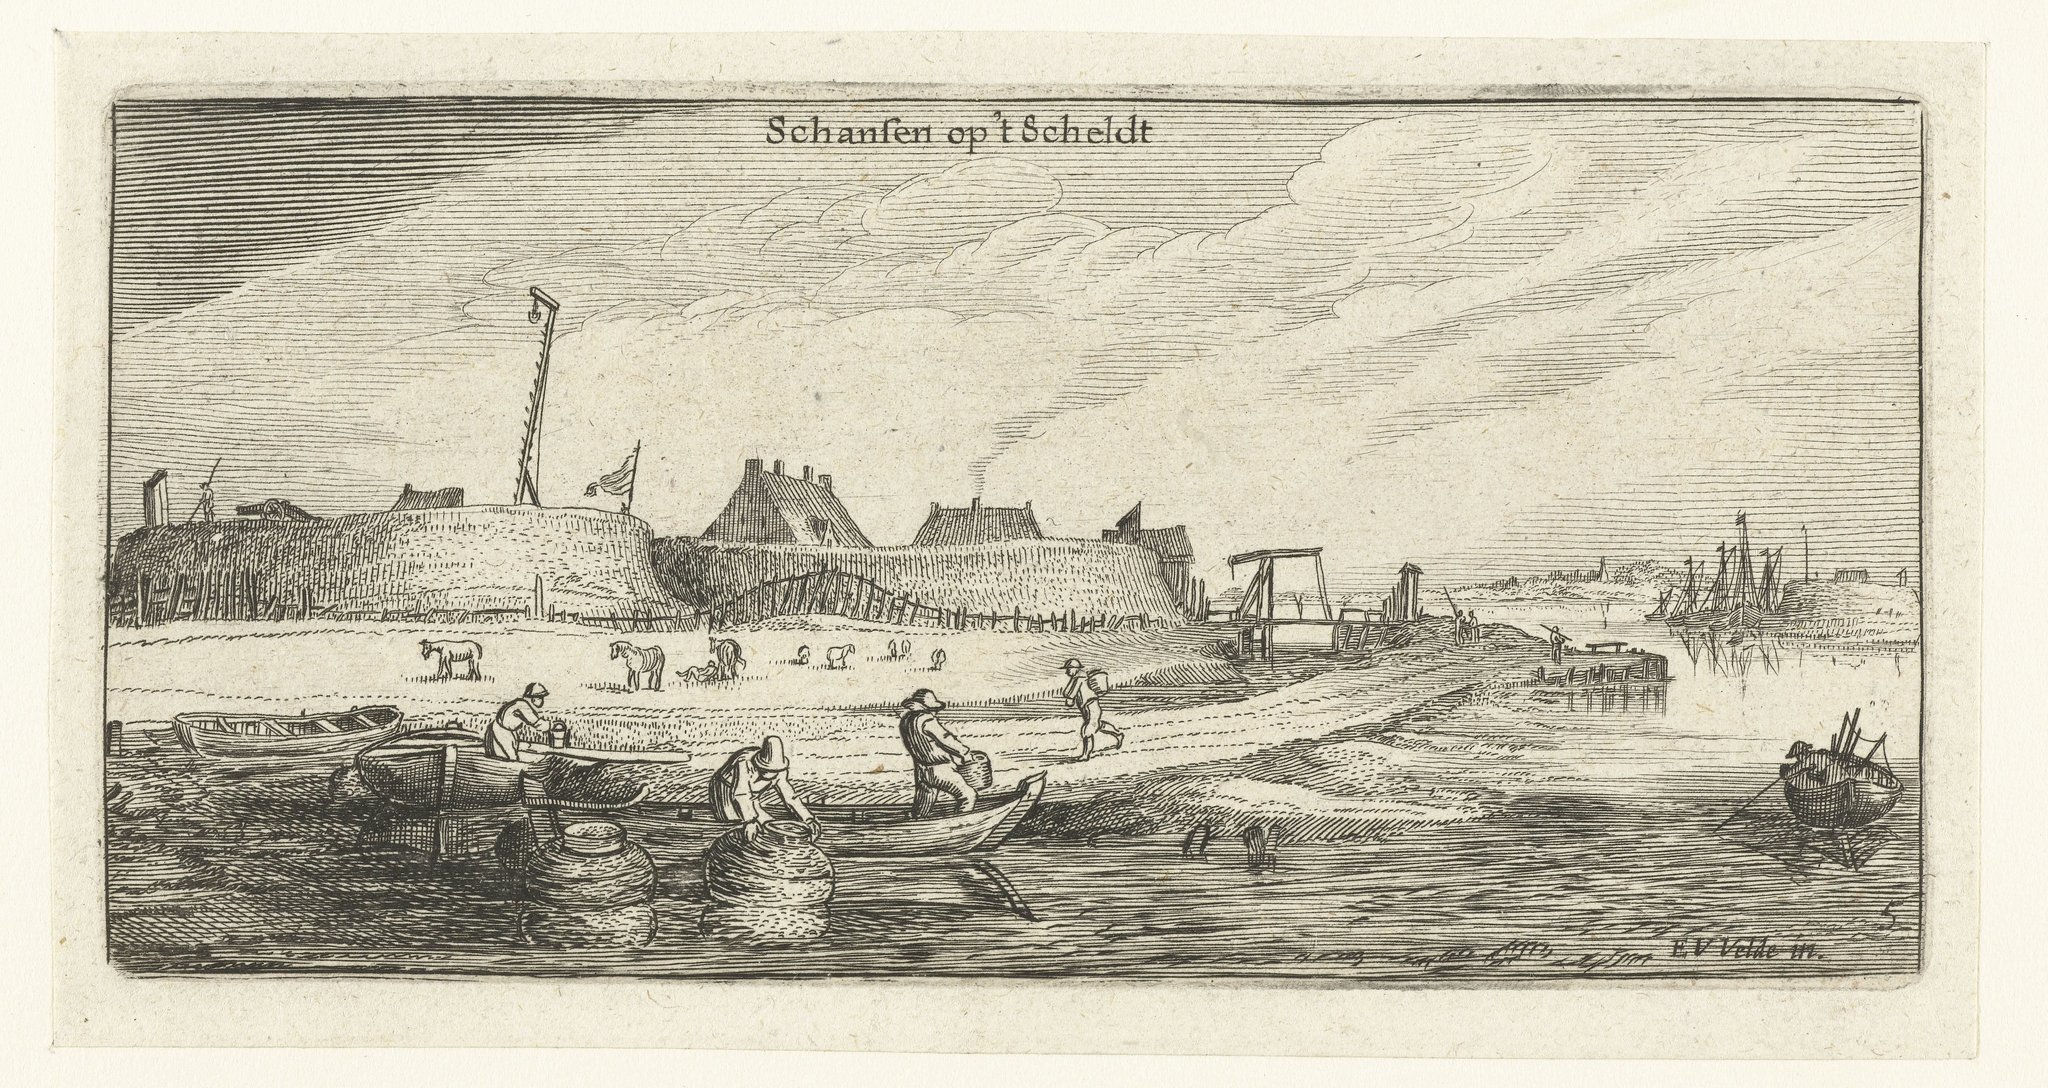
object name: print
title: Landschappen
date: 1615-1616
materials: paper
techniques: engraving, etching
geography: haarlem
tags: fortress, rowing-boat, canoe, etc., fisherman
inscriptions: collector's mark: Lugt 2228a